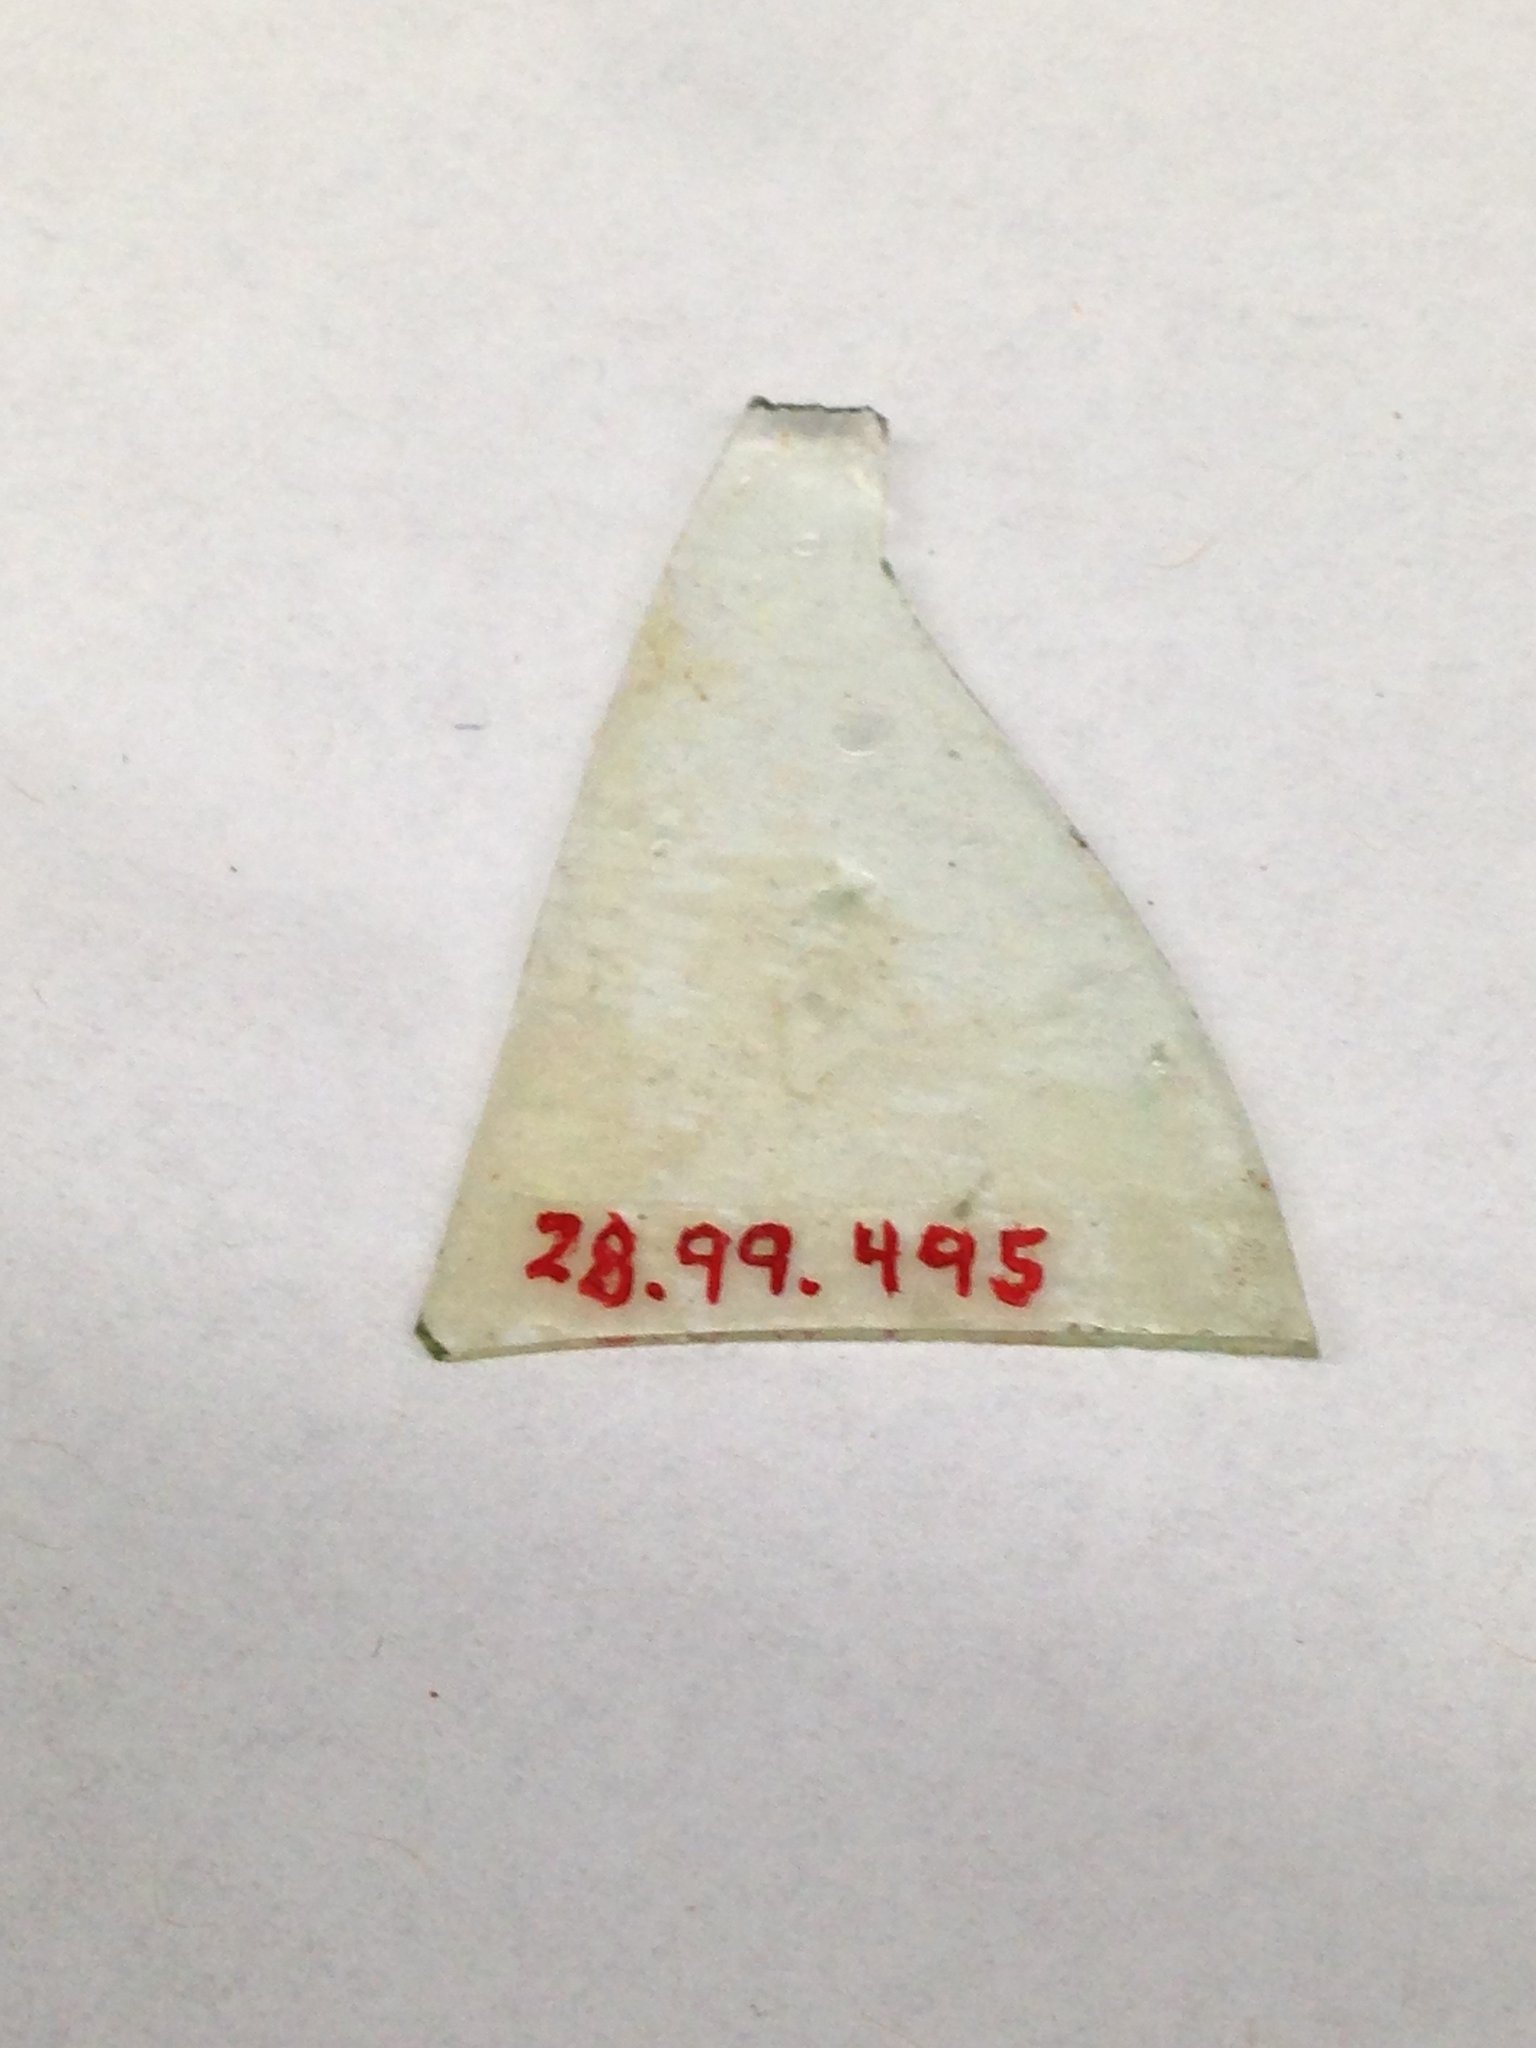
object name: fragment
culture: european or middle eastern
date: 1150-1250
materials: ceramic, glass